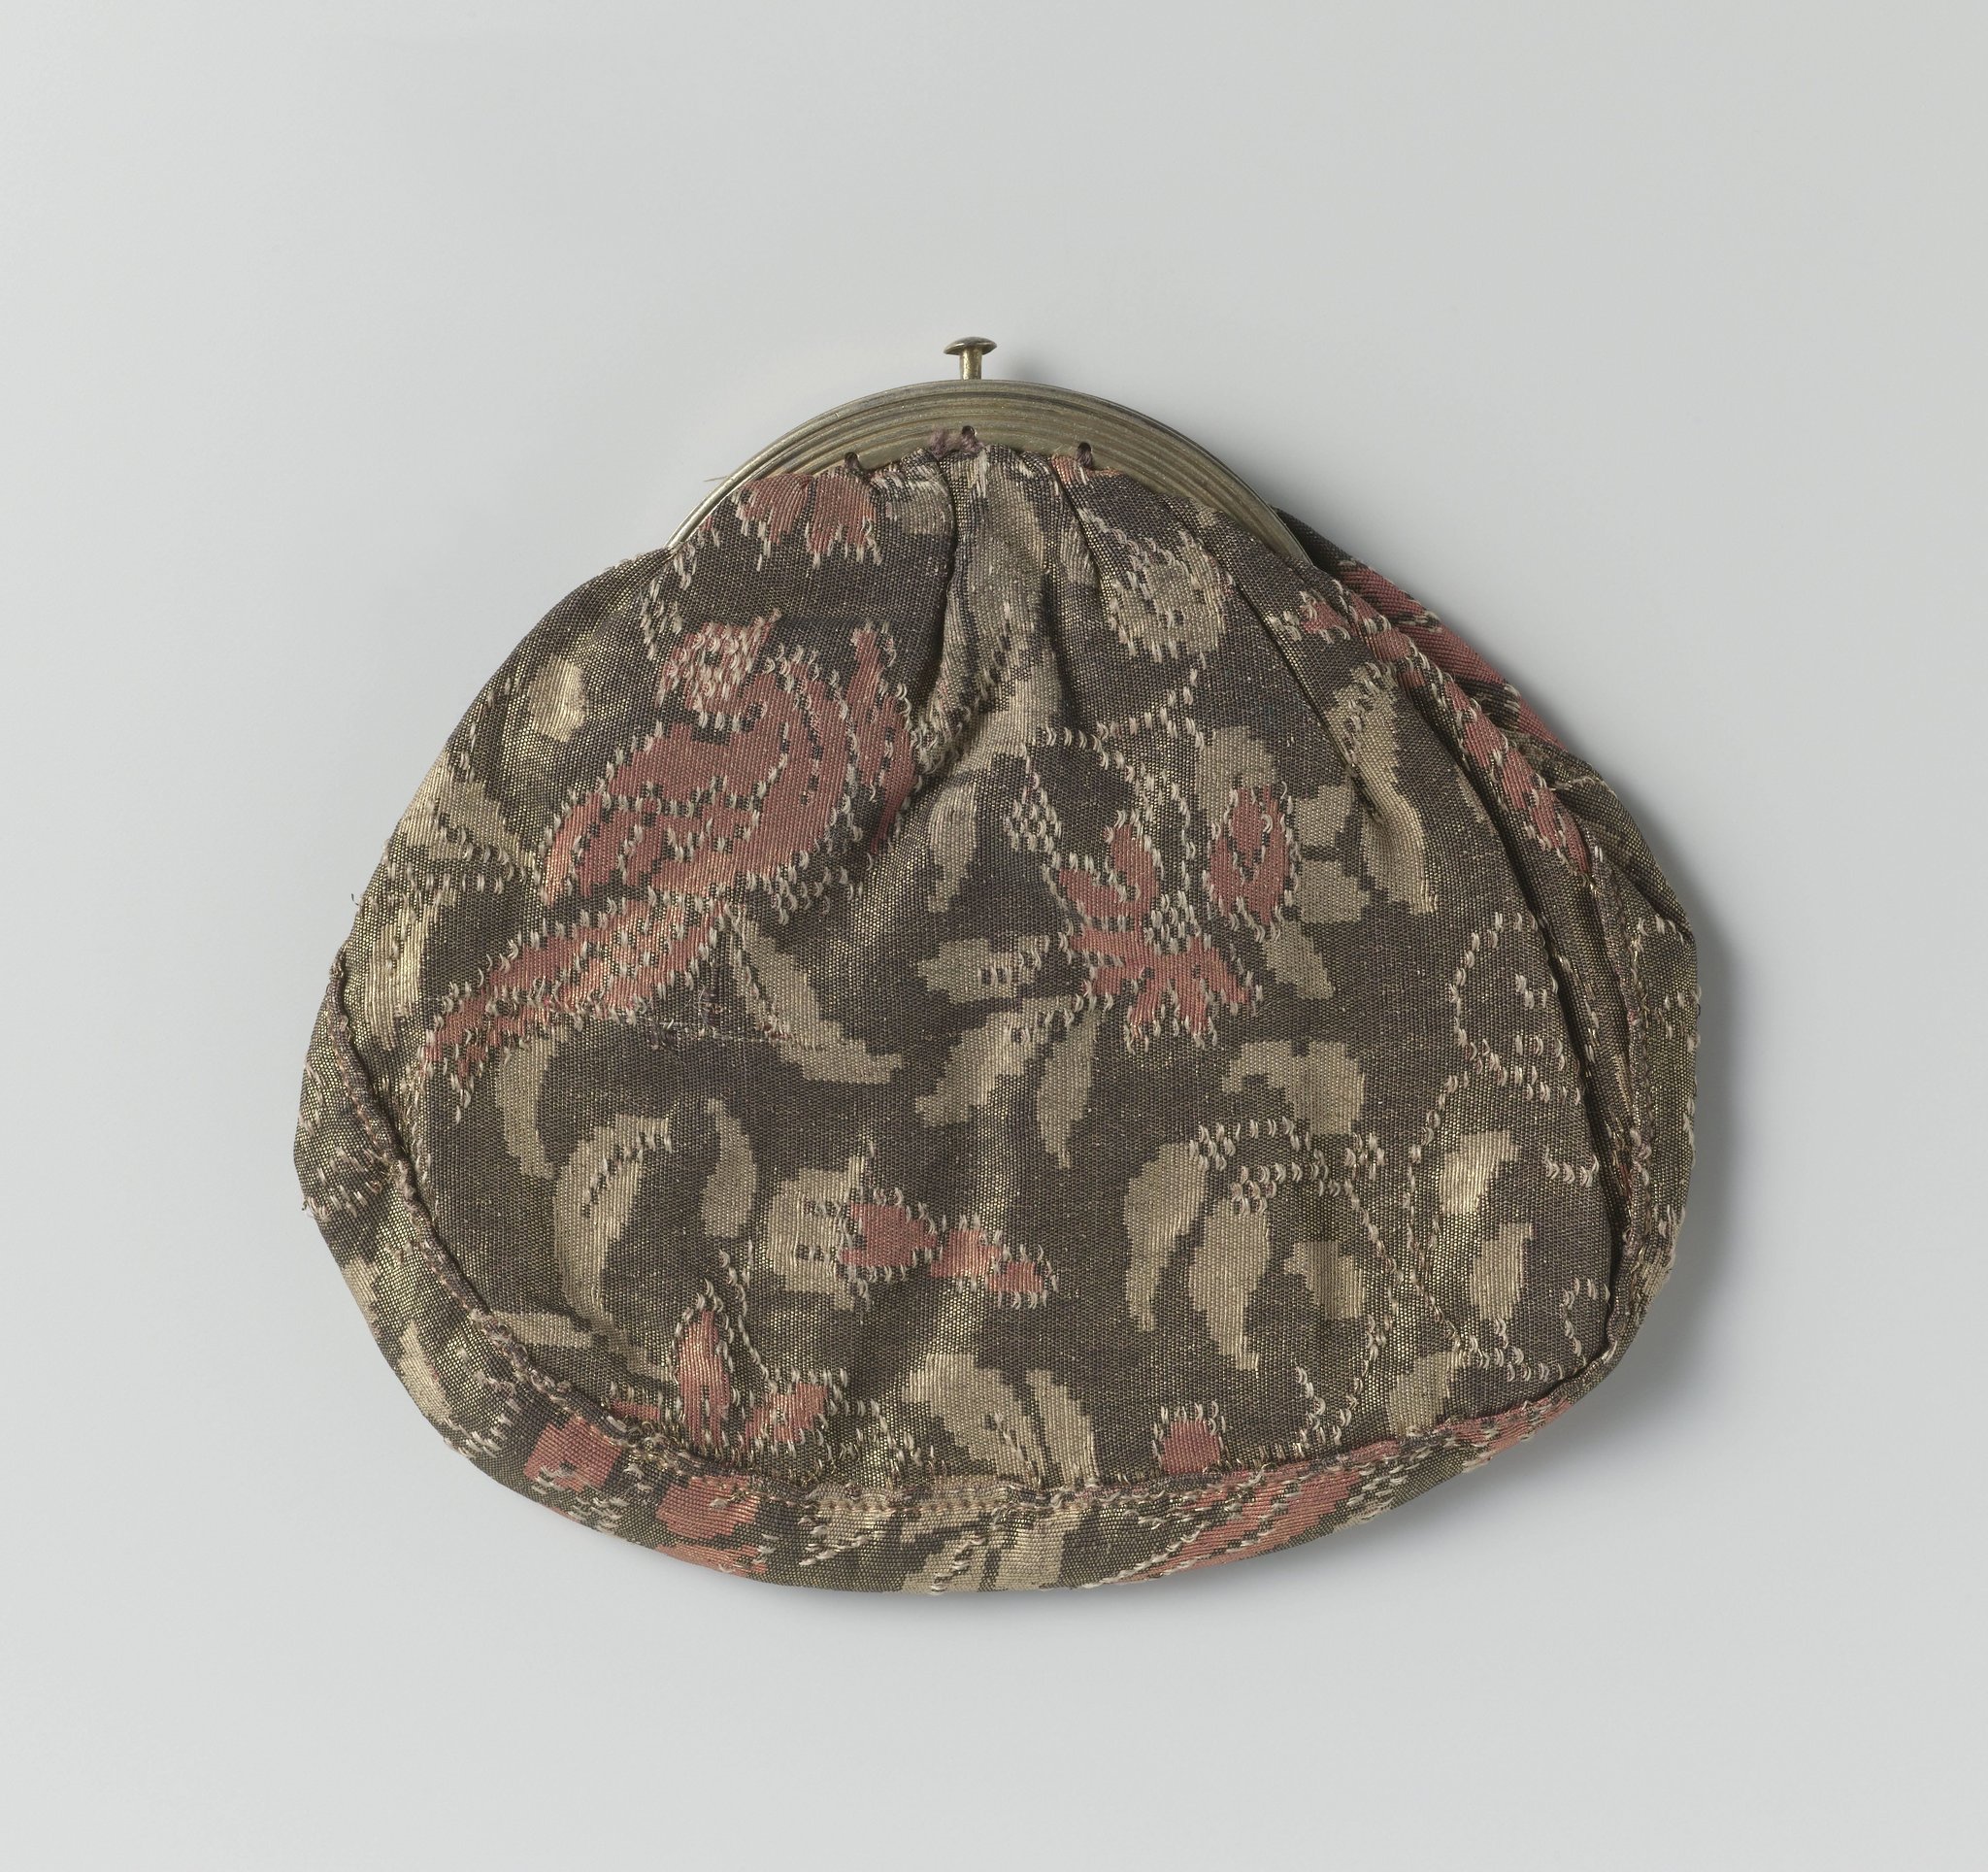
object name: beugeltas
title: Beugeltas in ovale vorm, van goudbrokaat met roze en bruin patroon van vogels en bloemen, aan een verguld zilveren beugel met knipsluiting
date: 1808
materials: gold thread, silk, silver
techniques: brocade, forging, gilding, weave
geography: asia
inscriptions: mold mark: ‘J.W.’, silver mark: ‘10’, silver mark: ‘ovaaltje met dwarsbaan’, silver mark: ‘b’, silver mark: ‘d.i.’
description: Beugeltas in ovale vorm, van goudbrokaat met roze en bruin patroon van vogels, bloemen en bladeren. Tussen de twee panden een strook stof van hetzelfde materiaal, net als het korte hengsel, dat de vorm heeft van een lus. De tas heeft een verguld zilveren beugel in een halfronde vorm met een gladde bovenkant en zijkanten met gleuven in reliëf. Bovenop een knipsluiting. De tas is gevoerd met oranjeroze changeant zijde en heeft een extra vak met een enkele vergulden beugel. tegen de buitenste beugel een lint van gouddraad.